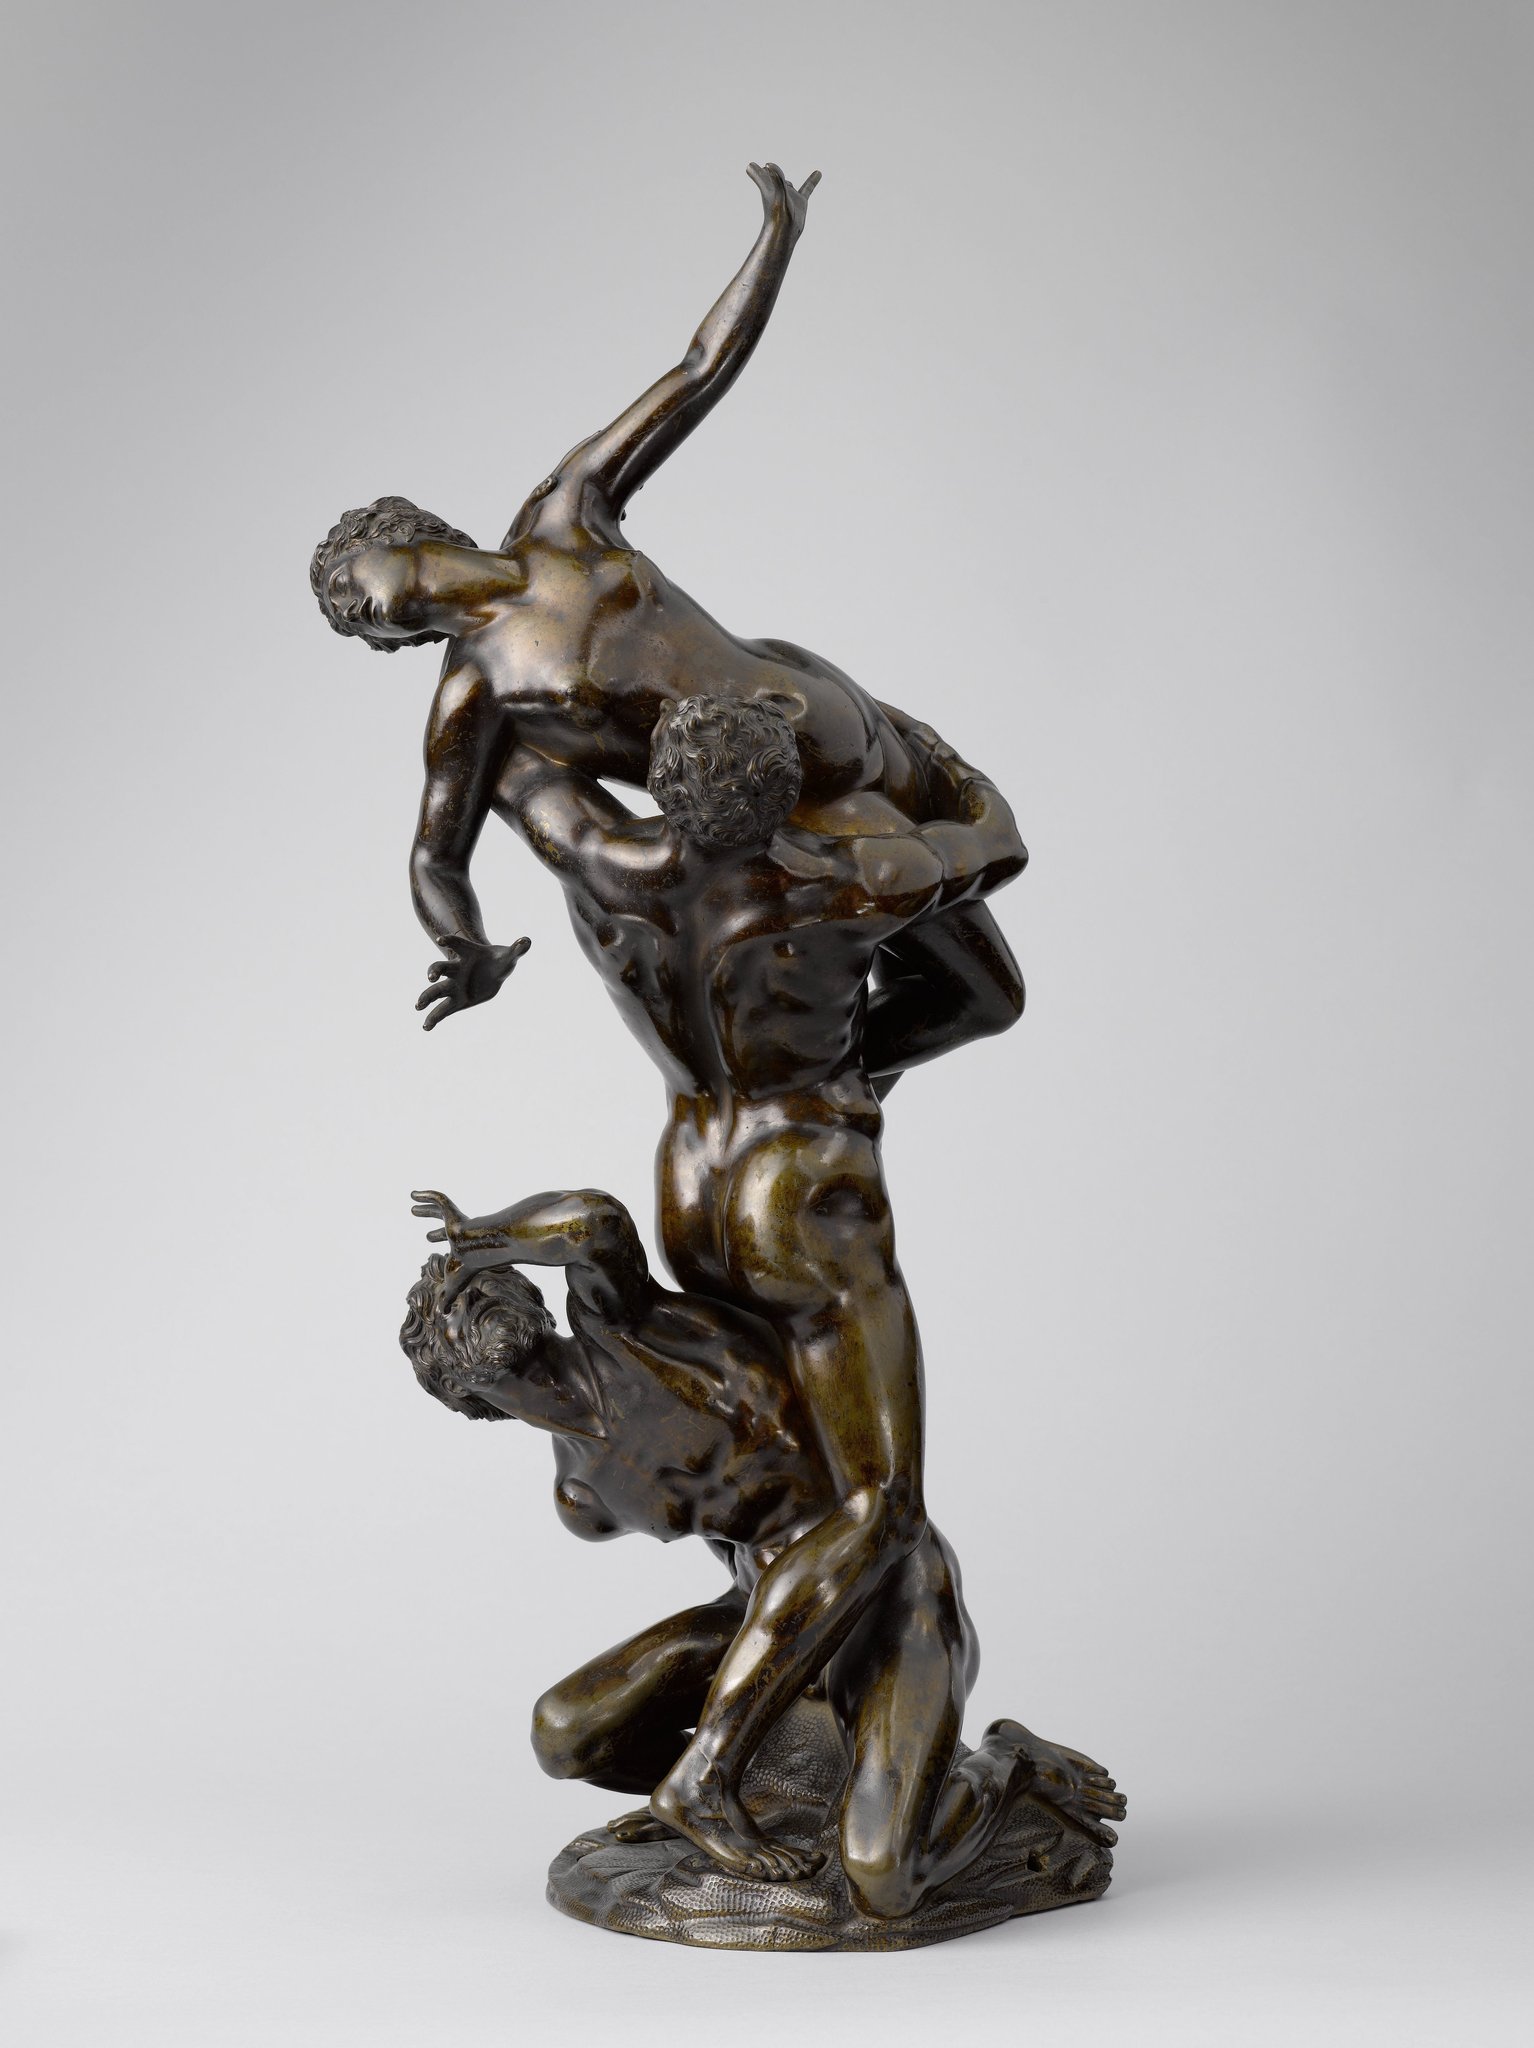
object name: figure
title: The Rape of a Sabine Woman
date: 1600-1625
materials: bronze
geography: florence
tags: rape of the sabine women: they are carried off by romulus and his men during a feast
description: This complex group of three intertwined figures is a reduced copy of the monumental marble sculpture Giambologna made in 1583 for the Loggia dei Lanzi in Florence, where it stands to this day. The composition is so ingenious that the statuette looks beautiful from all angles. This was quite an artistic challenge for sculptors in the late 16th century.